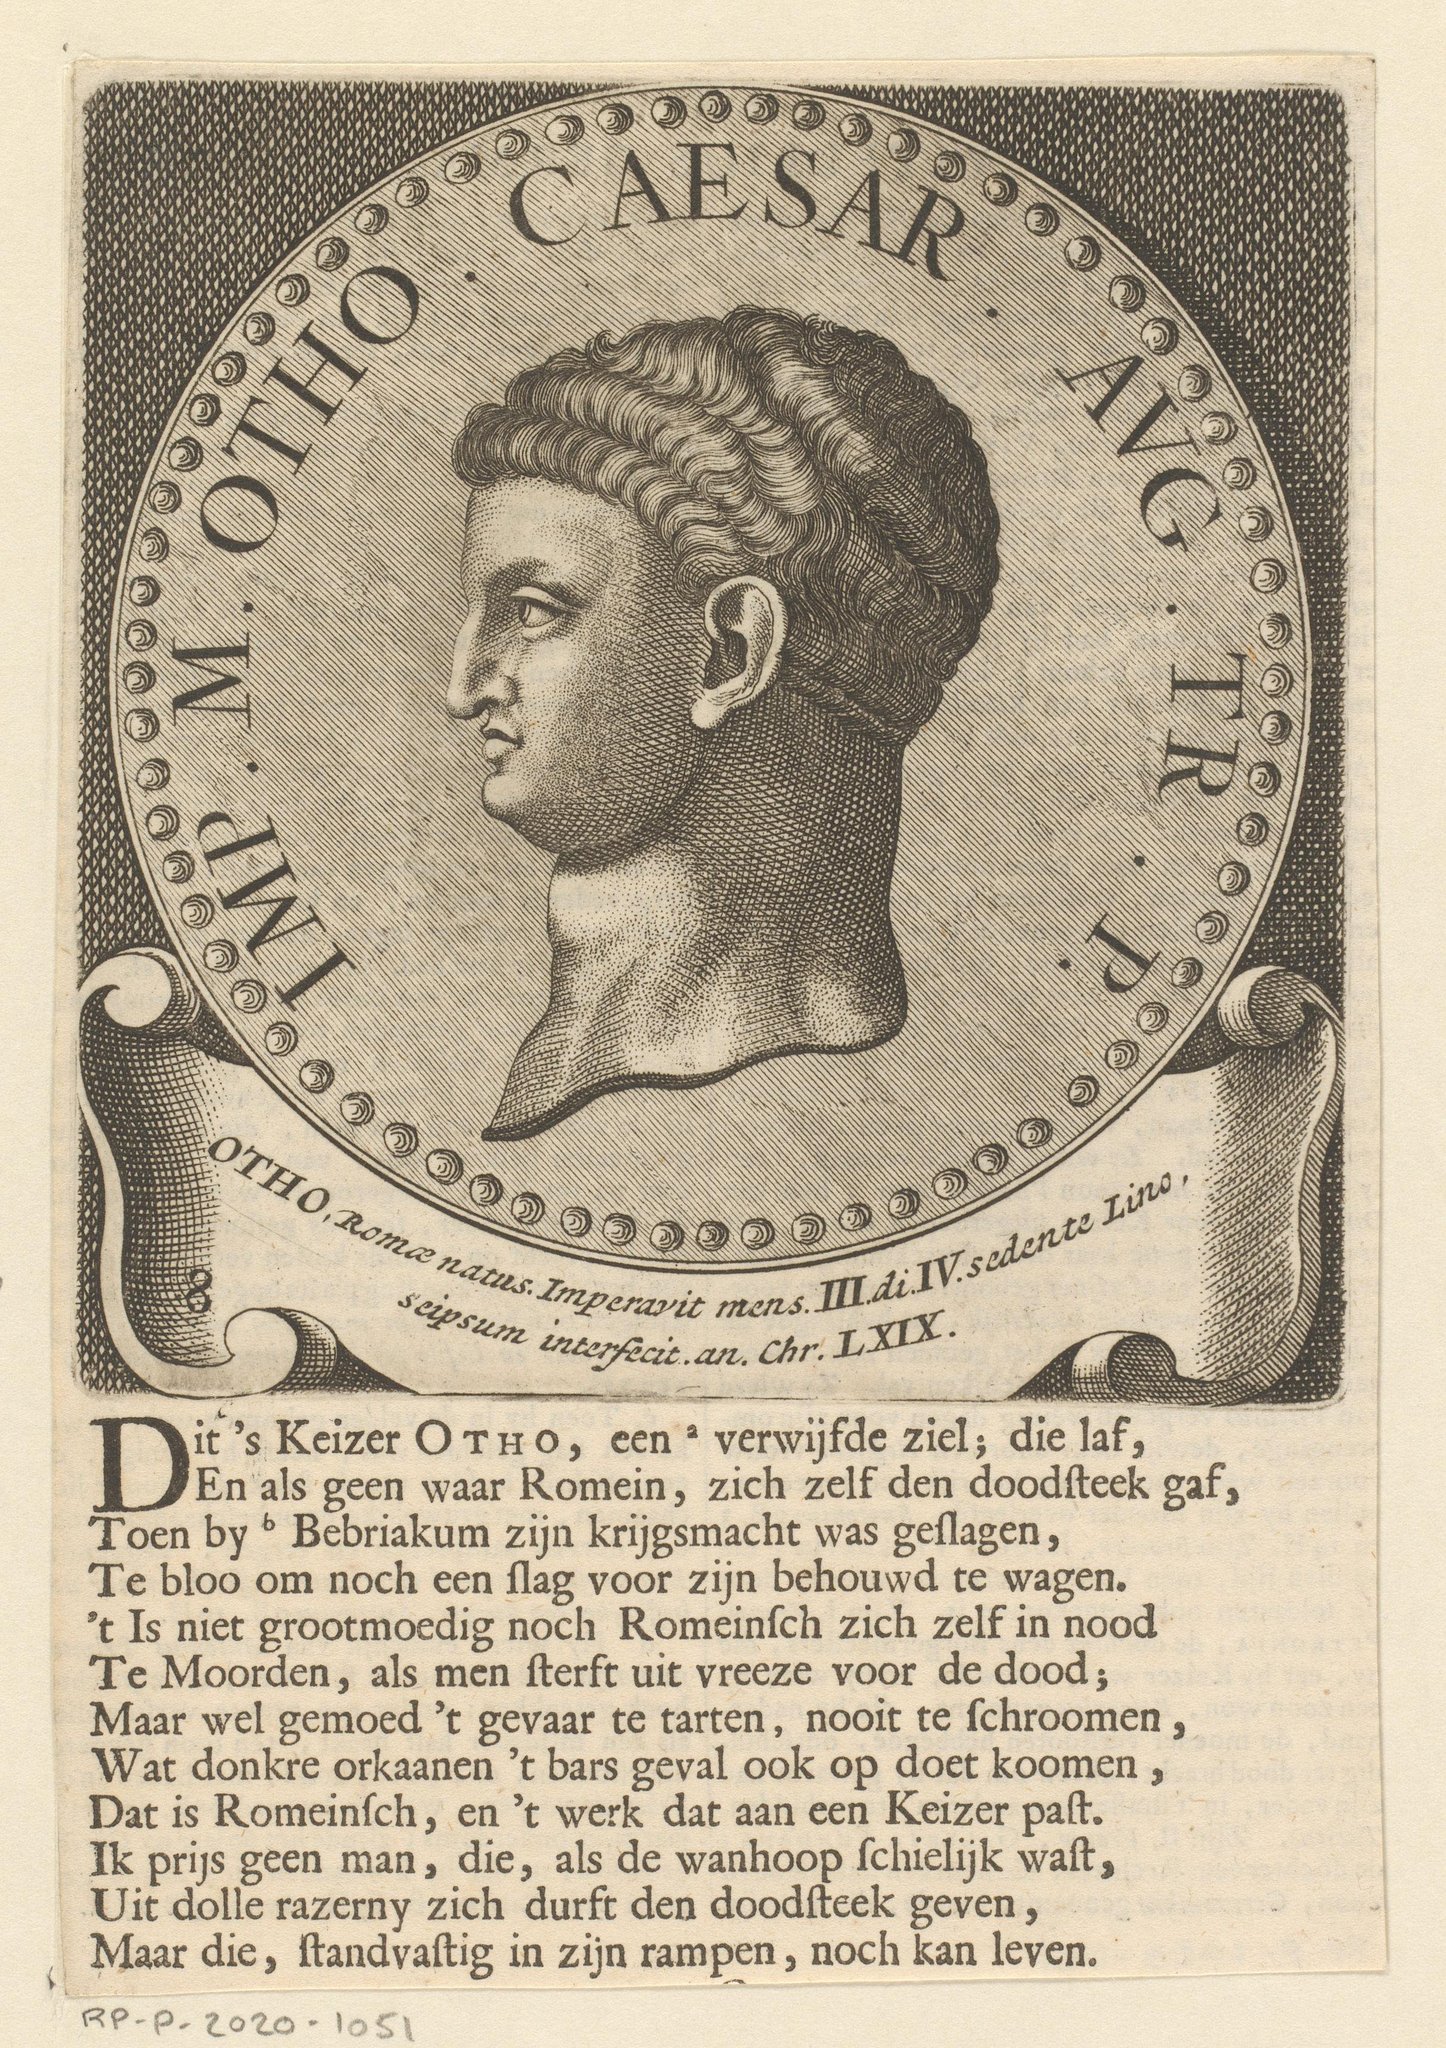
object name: print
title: Otho, Romae natus (...)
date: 1697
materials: paper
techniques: engraving, etching, letterpress printing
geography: utrecht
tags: historical persons, emperor, male persons from classical history (otho)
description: Prent uit: Bogaert, Abraham. De Roomsche monarchy, vertoont in de muntbeelden der westersche en oostersche keizeren (...). Utrecht: François Halma en Willem van de Water, 1697, p. 123. Eerste staat verschenen in een grotere prent met twaalf portretten, gedateerd 1695.